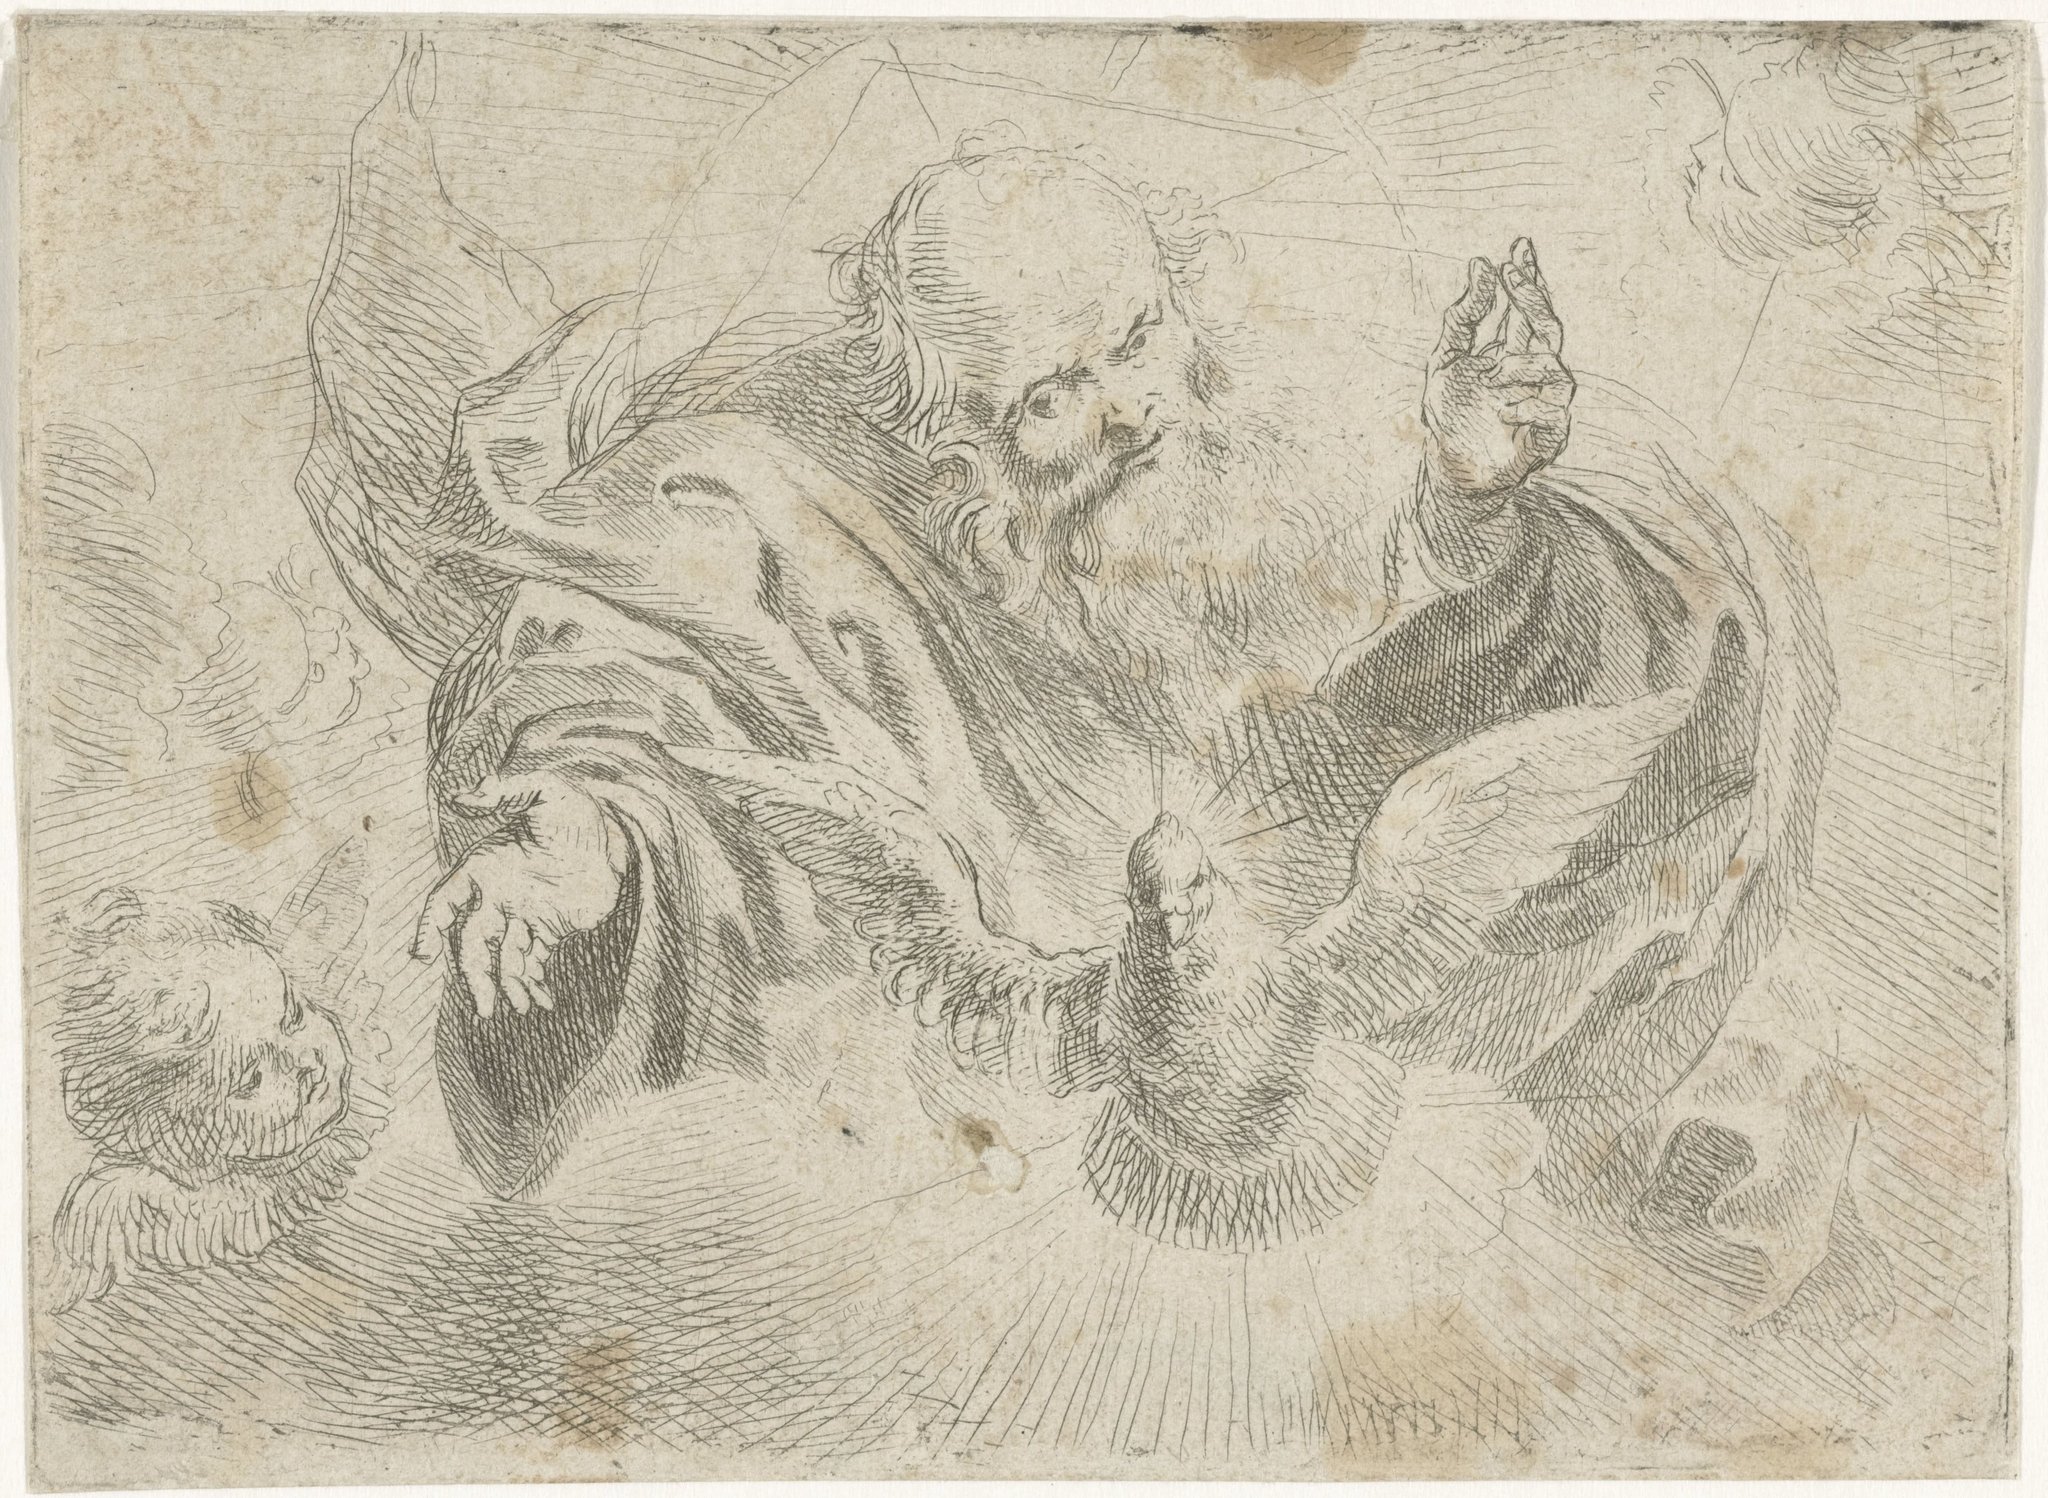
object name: print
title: God de Vader met de duif van de Heilige Geest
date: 1633-1664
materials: paper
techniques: etching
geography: italy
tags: cherubs, i.e. children's heads with wings, god the father, holy ghost represented as a dove (in flames)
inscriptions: collector's mark: Lugt 240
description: God de Vader en de duif van de Heilige Geest. Linksonder en rechtsboven cherubijnen.